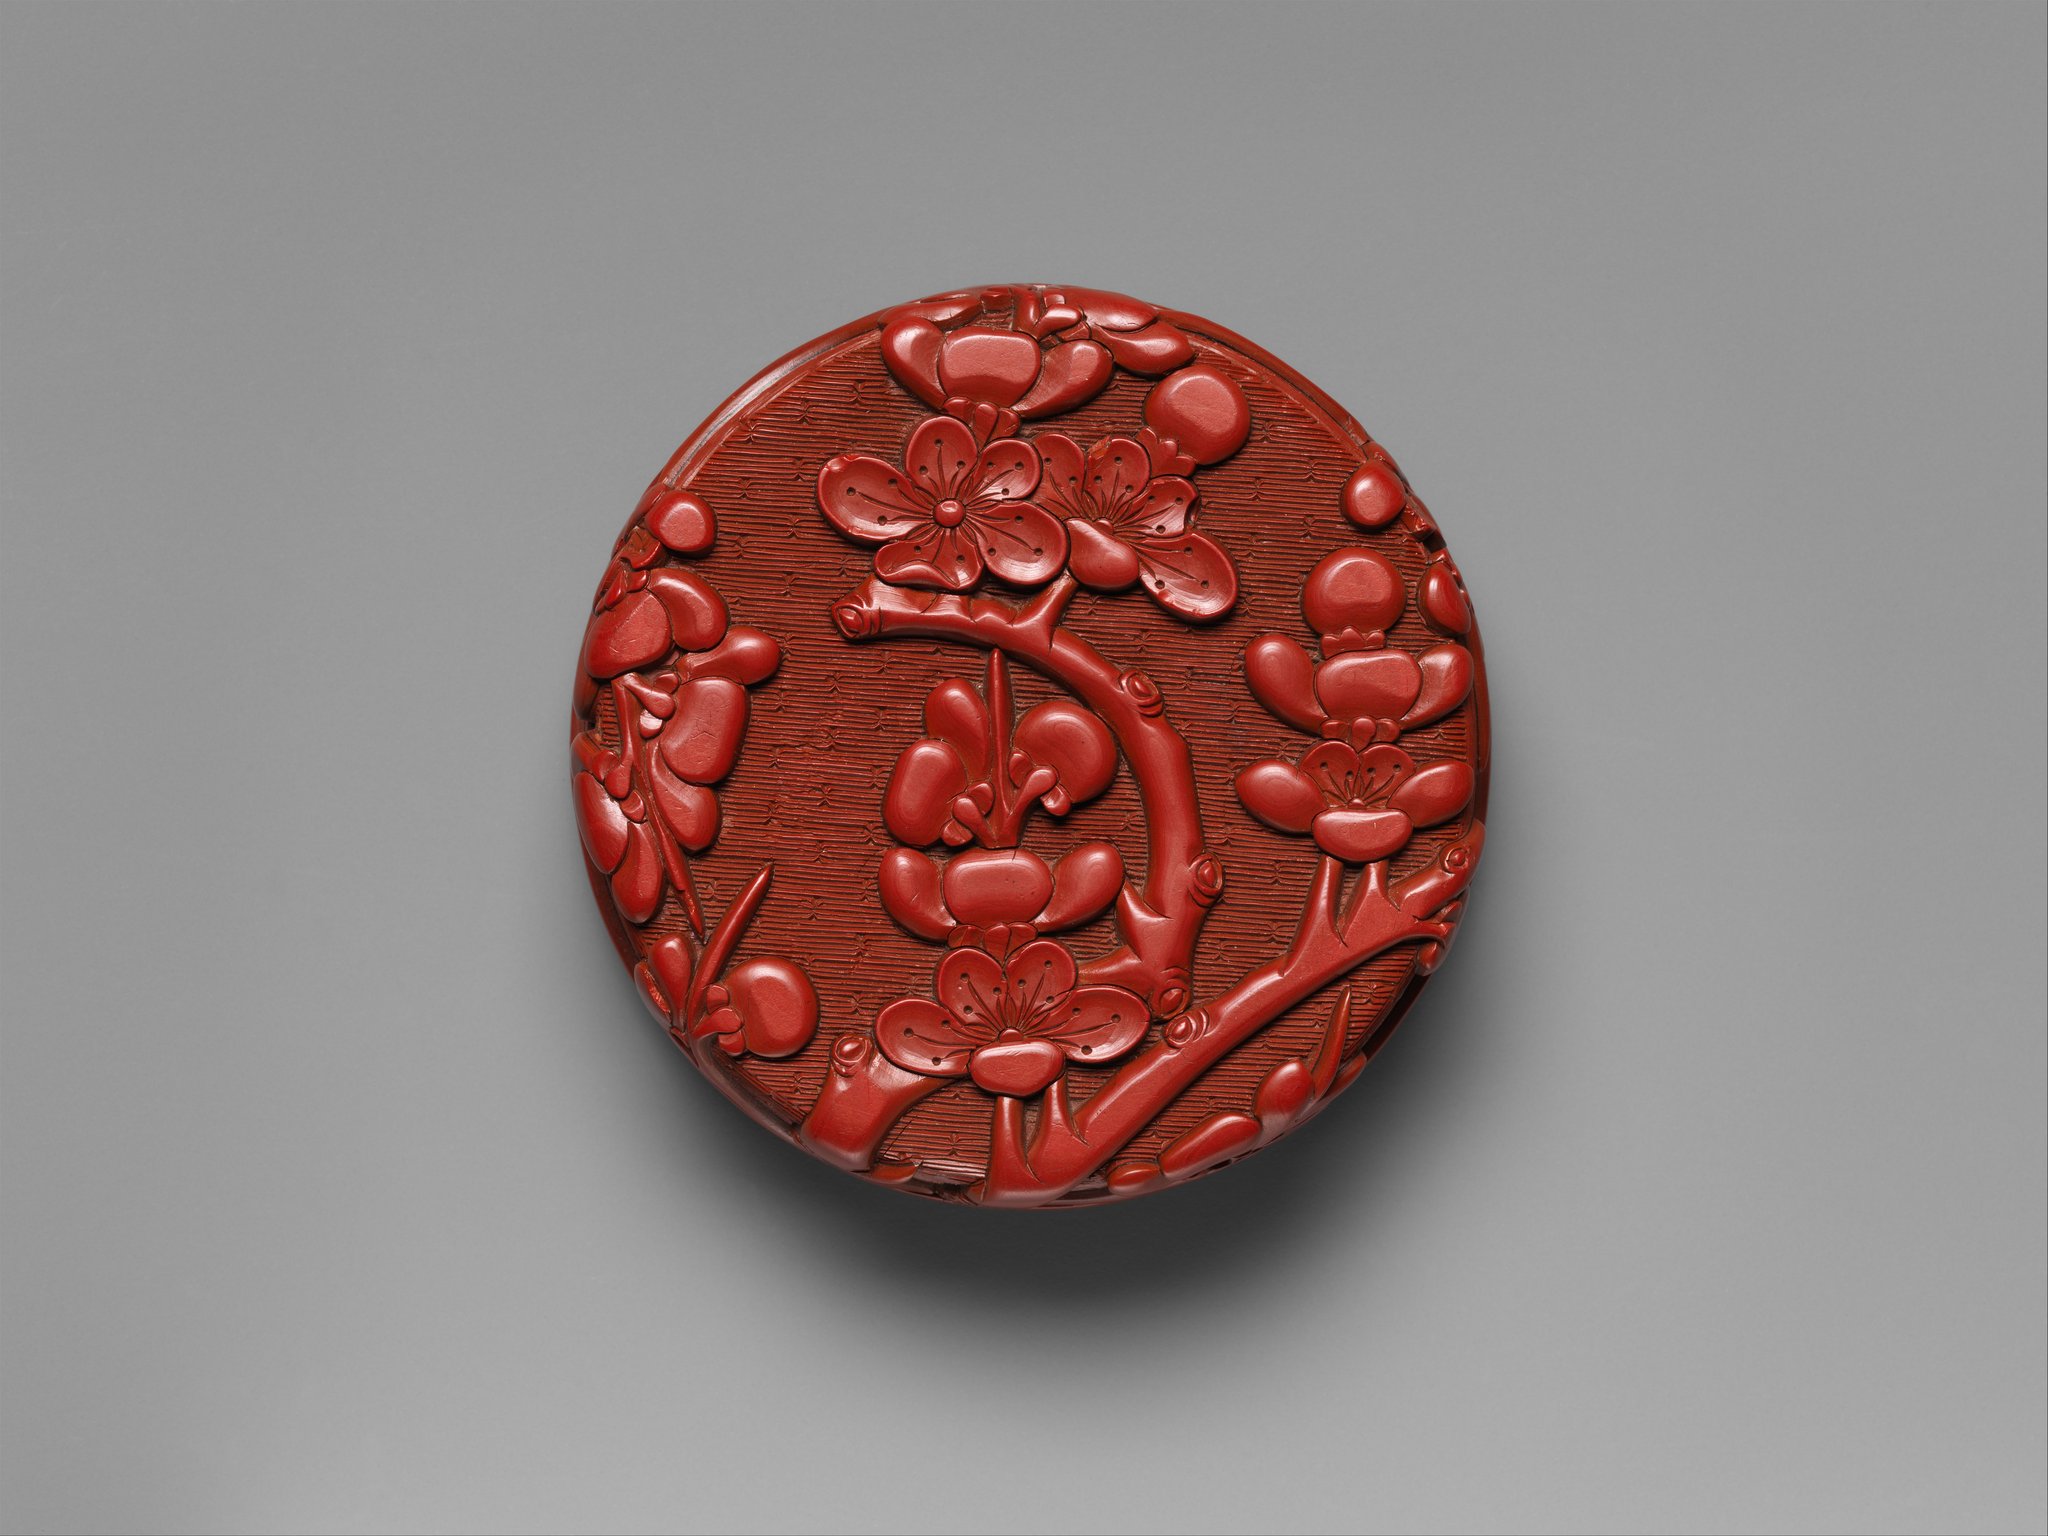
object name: box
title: Box with plum spray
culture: chinese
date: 1501-1600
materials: lacquer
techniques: carving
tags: flowers